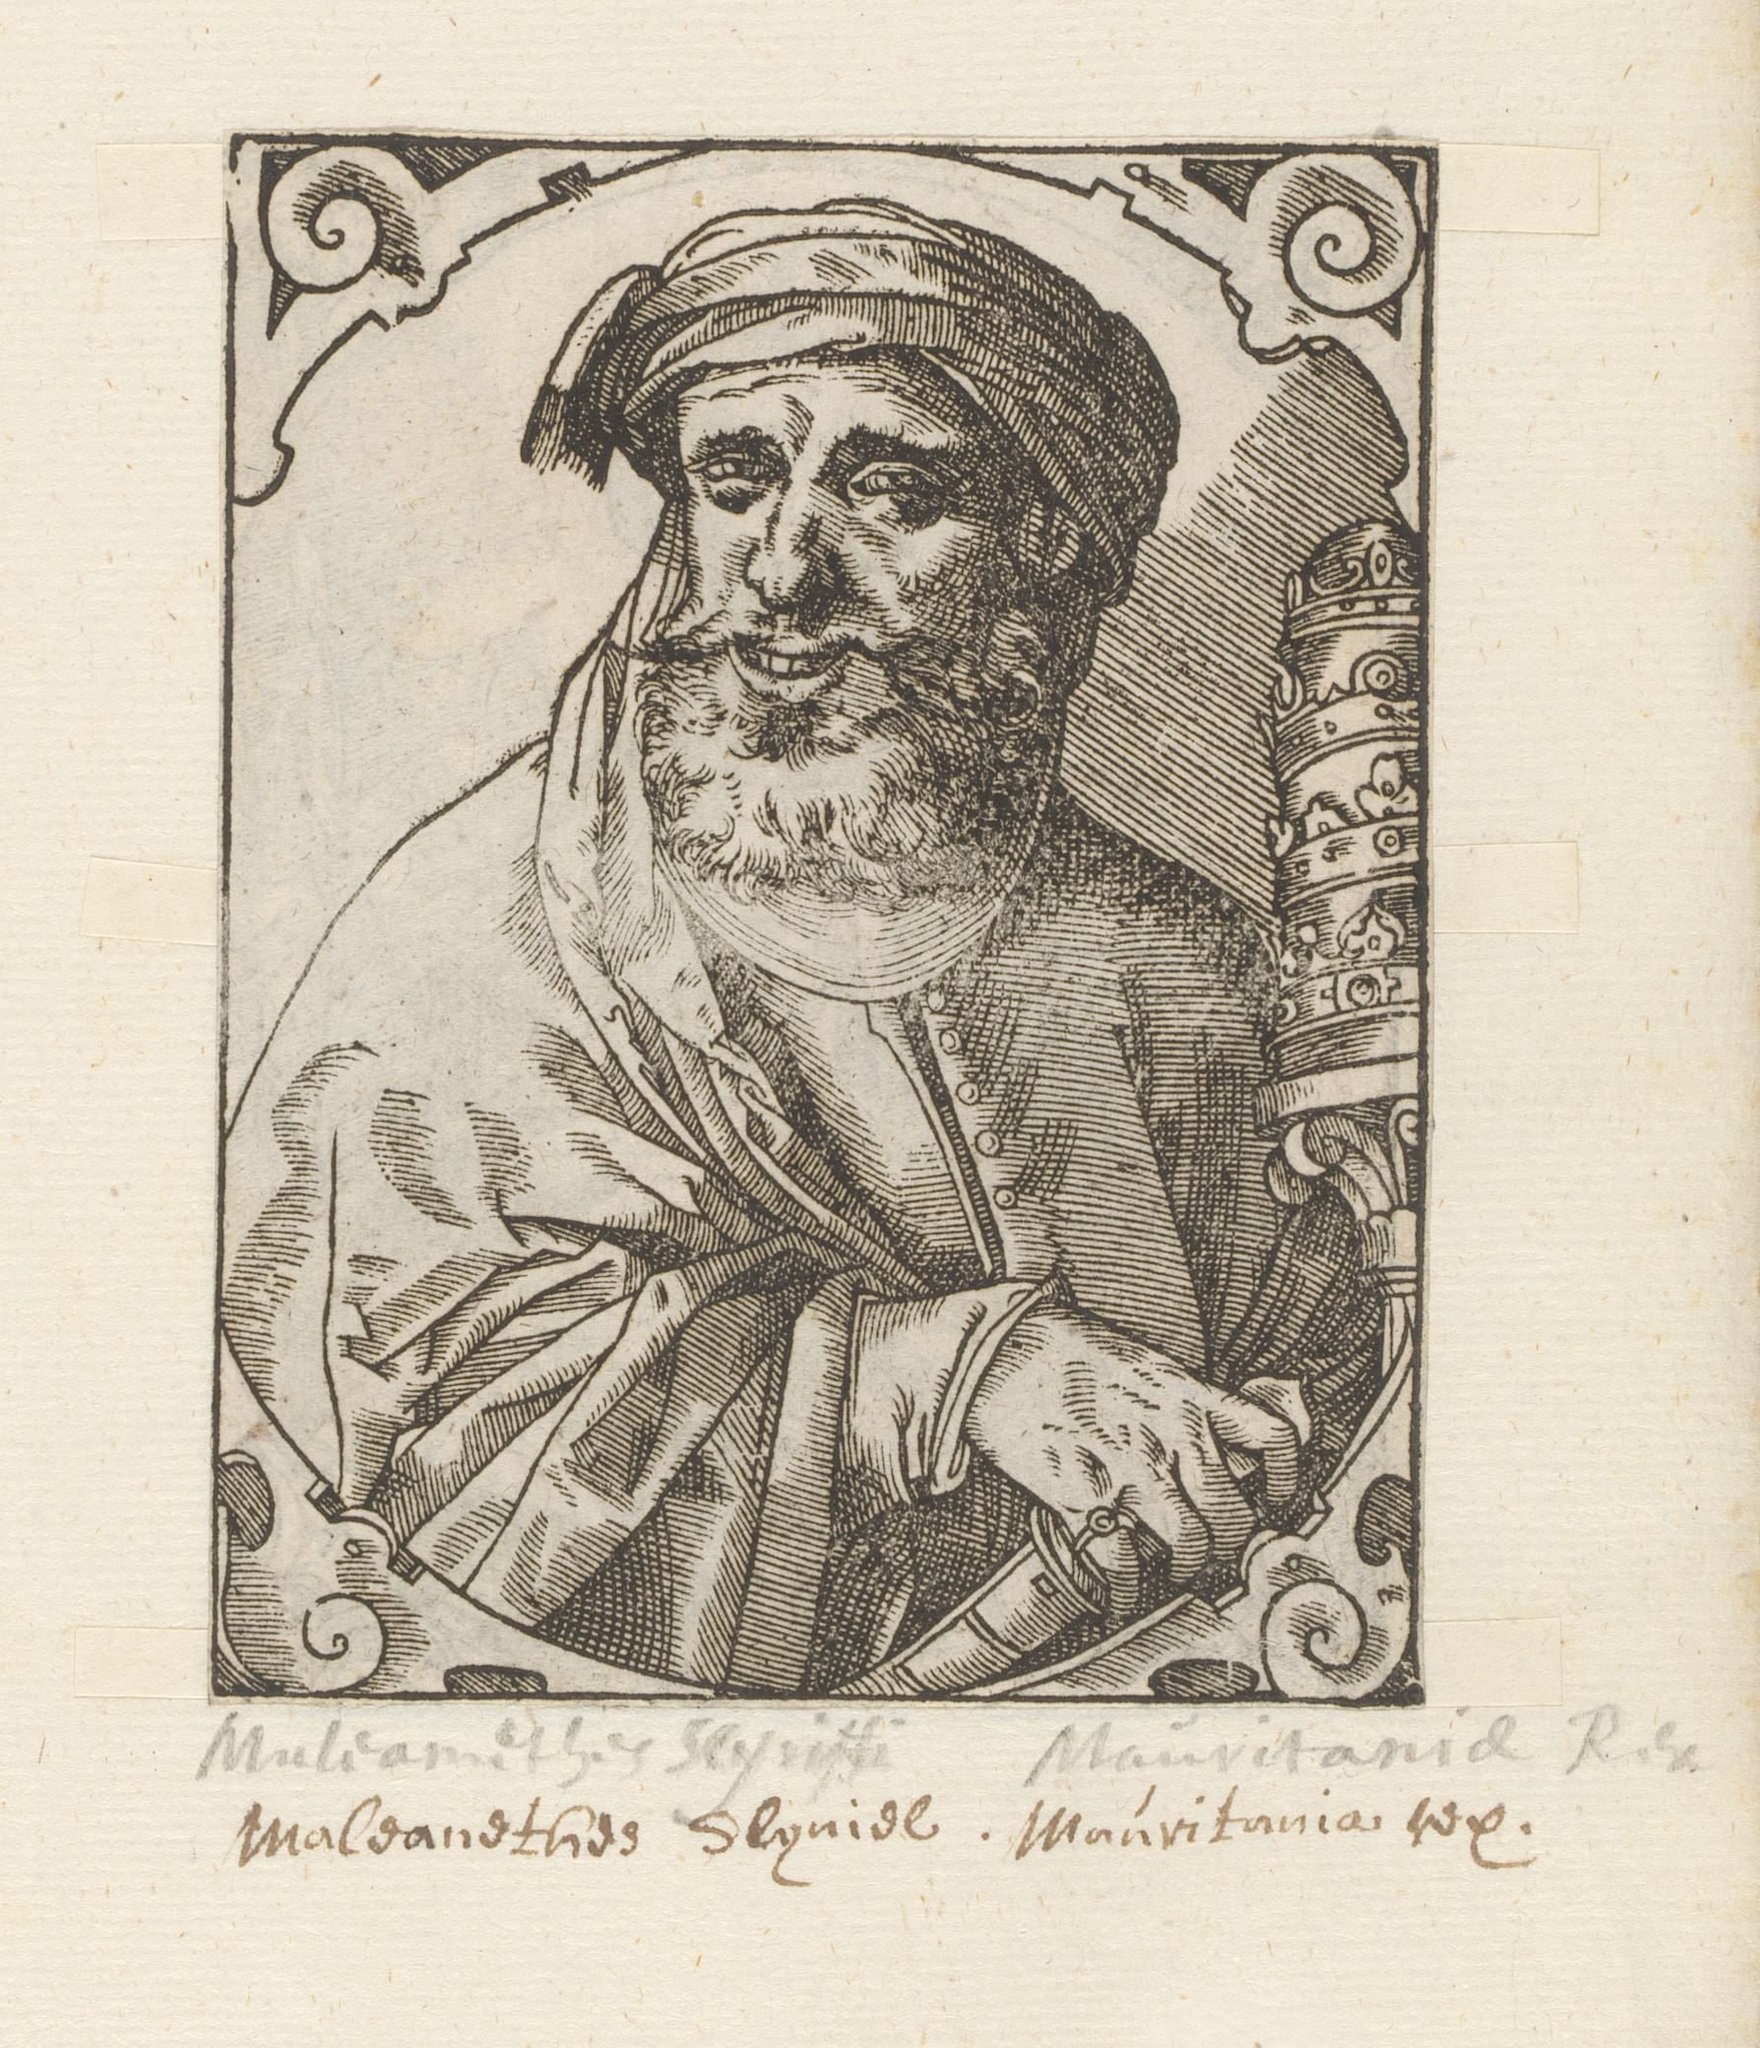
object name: album leaf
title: Portret van Muleamethes Scyriffi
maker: Anonymous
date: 1549-1575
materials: paper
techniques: woodcut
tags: historical persons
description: Prent gebruikt in: Giovio, Paolo. Elogia Virorum bellica virtute illustrium (...). Bazel: Peter Perna, 1575.